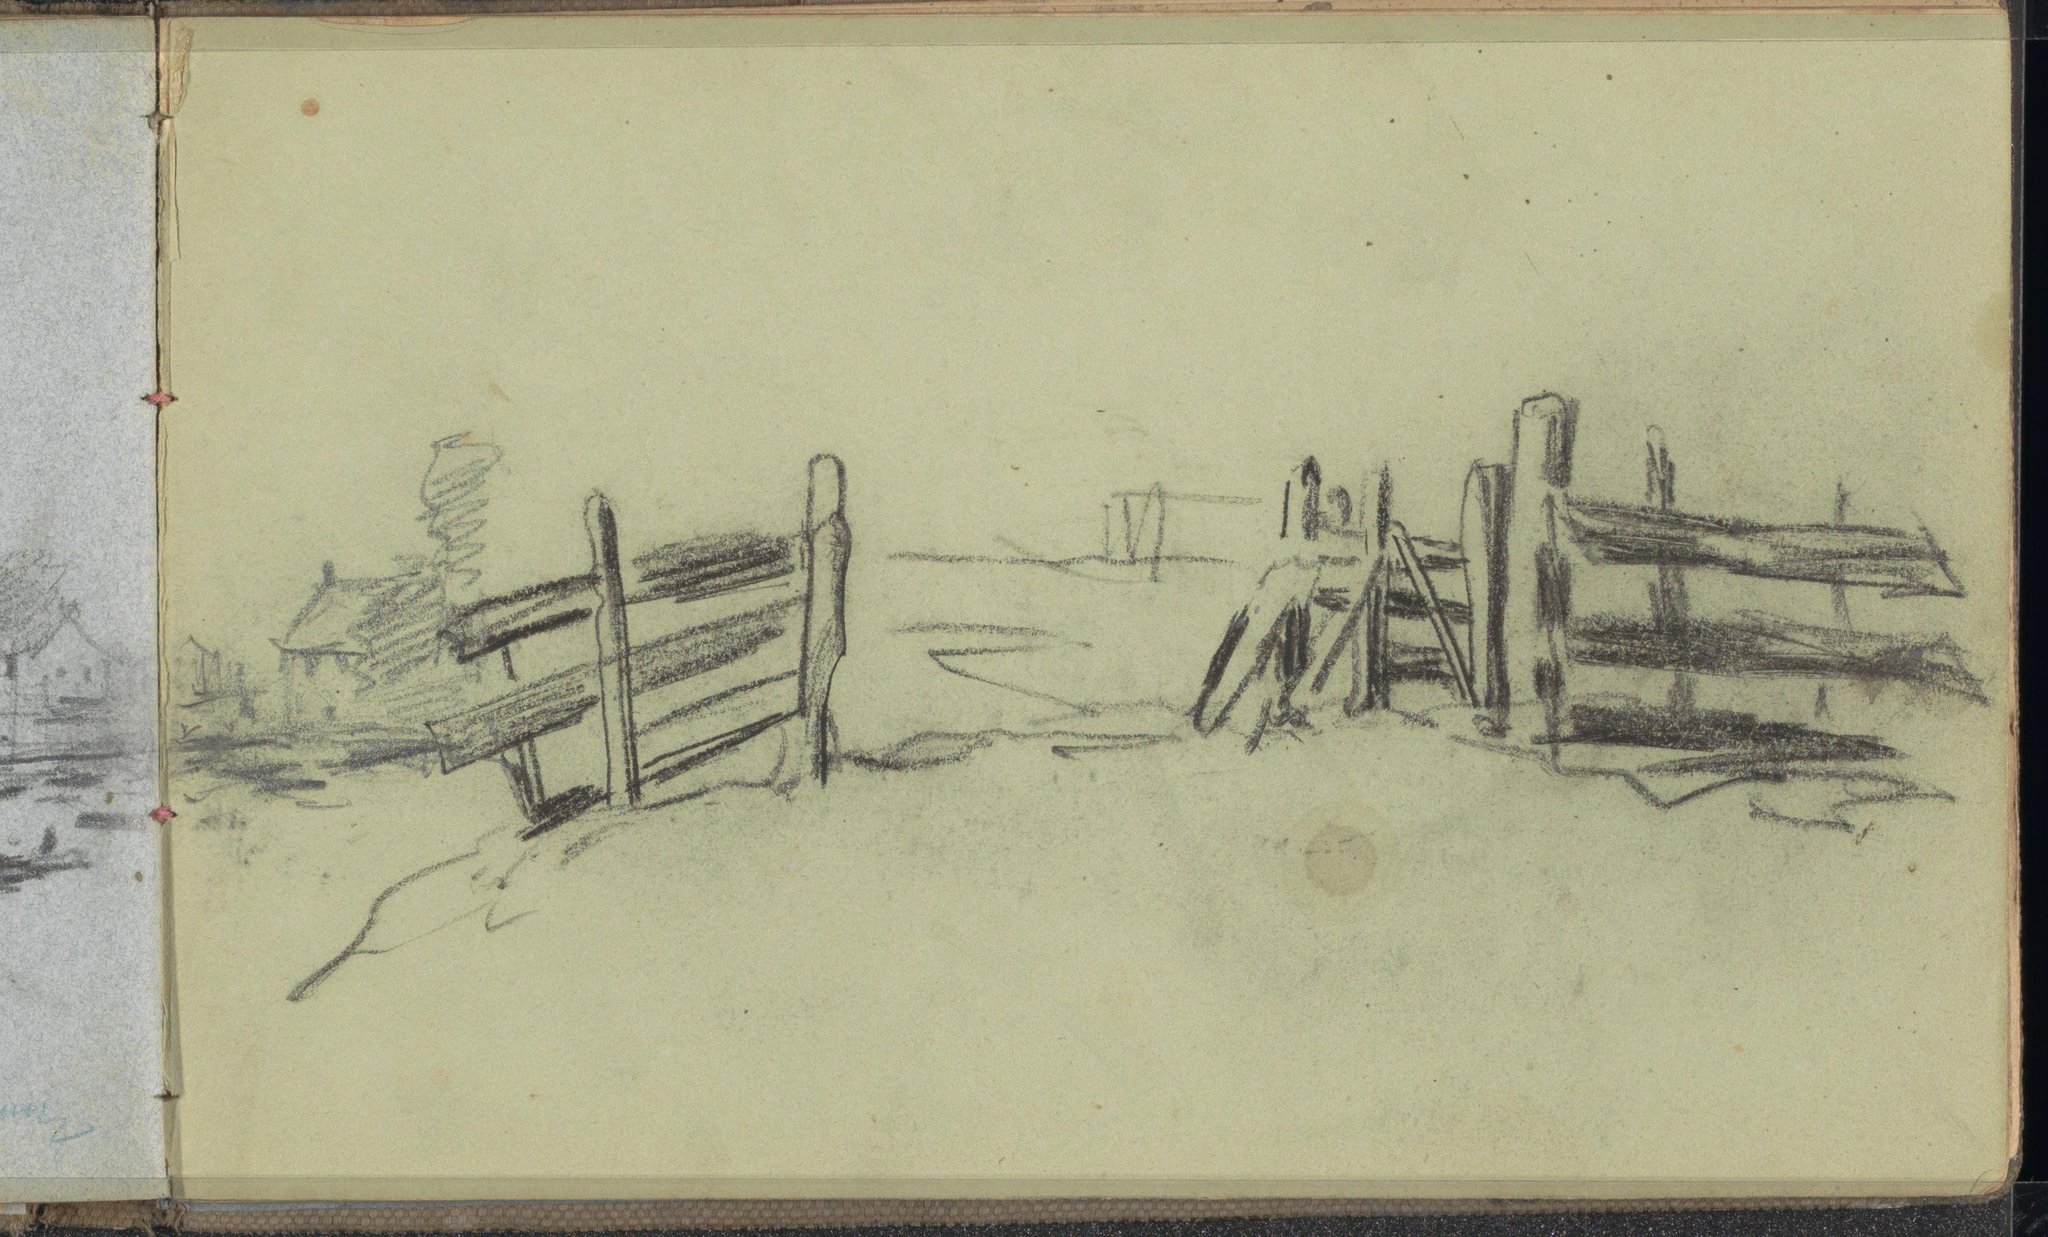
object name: sketchbook leaf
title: Figuren op een pontonbrug en een openstaand hek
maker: louis apol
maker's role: draughtsman, painter, print maker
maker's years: 1850-1936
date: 1880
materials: chalk, paper, pencil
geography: norway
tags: fence, wall, paling, pontoon bridge, city-view, and landscape with man-made constructions (+ city(-scape) with figures, staffage), norway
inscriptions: annotation: ‘Pontenia[?] Noorwegen[?]’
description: In de verte bebouwing. Blad 26 verso en blad 27 recto uit een schetsboek met 38 bladen betekend tijdens de expeditie naar Nova Zembla in 1880.